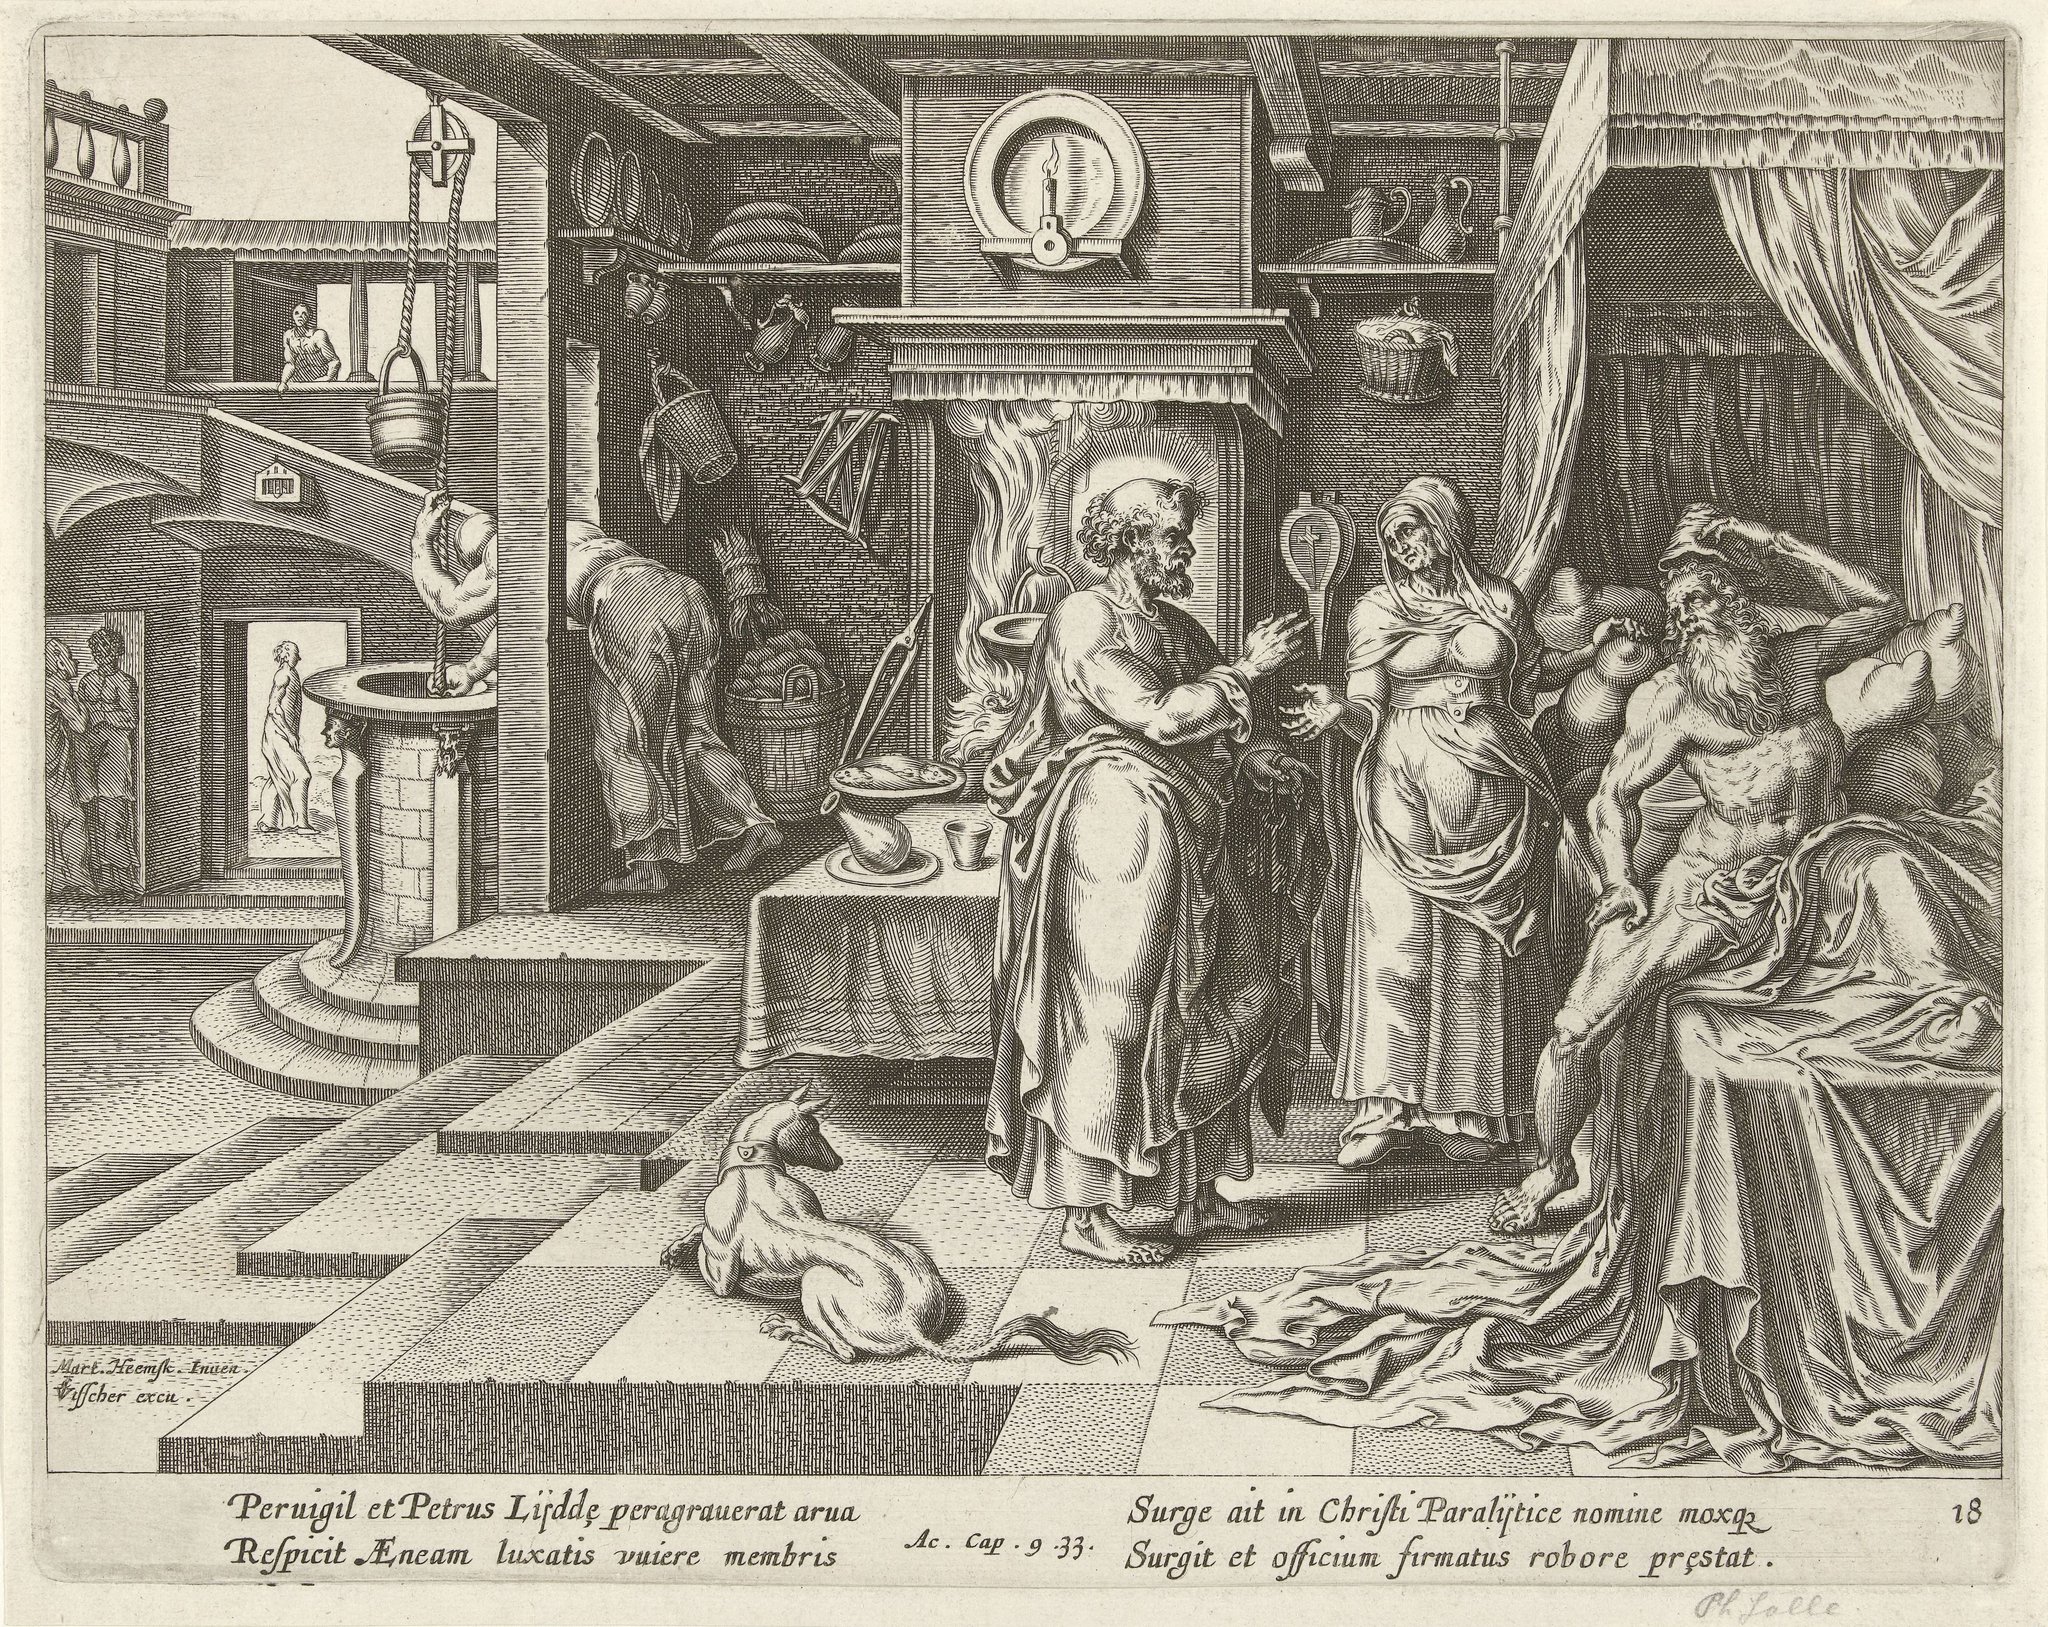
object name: print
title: Handelingen van de apostelen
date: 1643-1646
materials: paper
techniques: engraving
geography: amsterdam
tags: peter in lydda heals aeneas, who had been confined to his bed for eight years (acts 9:32-35)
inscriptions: collector's mark: Lugt 2228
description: De apostel Petrus geneest de verlamde Enias in Lydda. Hij zegent hem en beveelt hem op te staan uit in bed. De prent heeft een Latijns onderschrift en maakt deel uit van een 35-delige serie met als onderwerp de Handelingen van de apostelen.